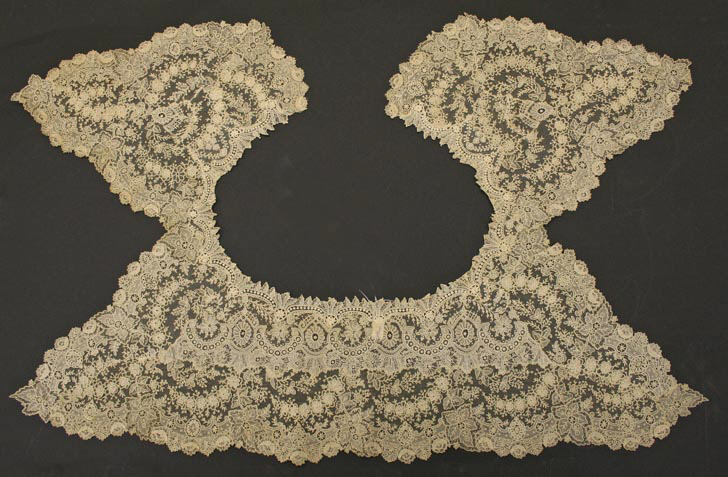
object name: bertha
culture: belgian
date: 1867-1900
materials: linen